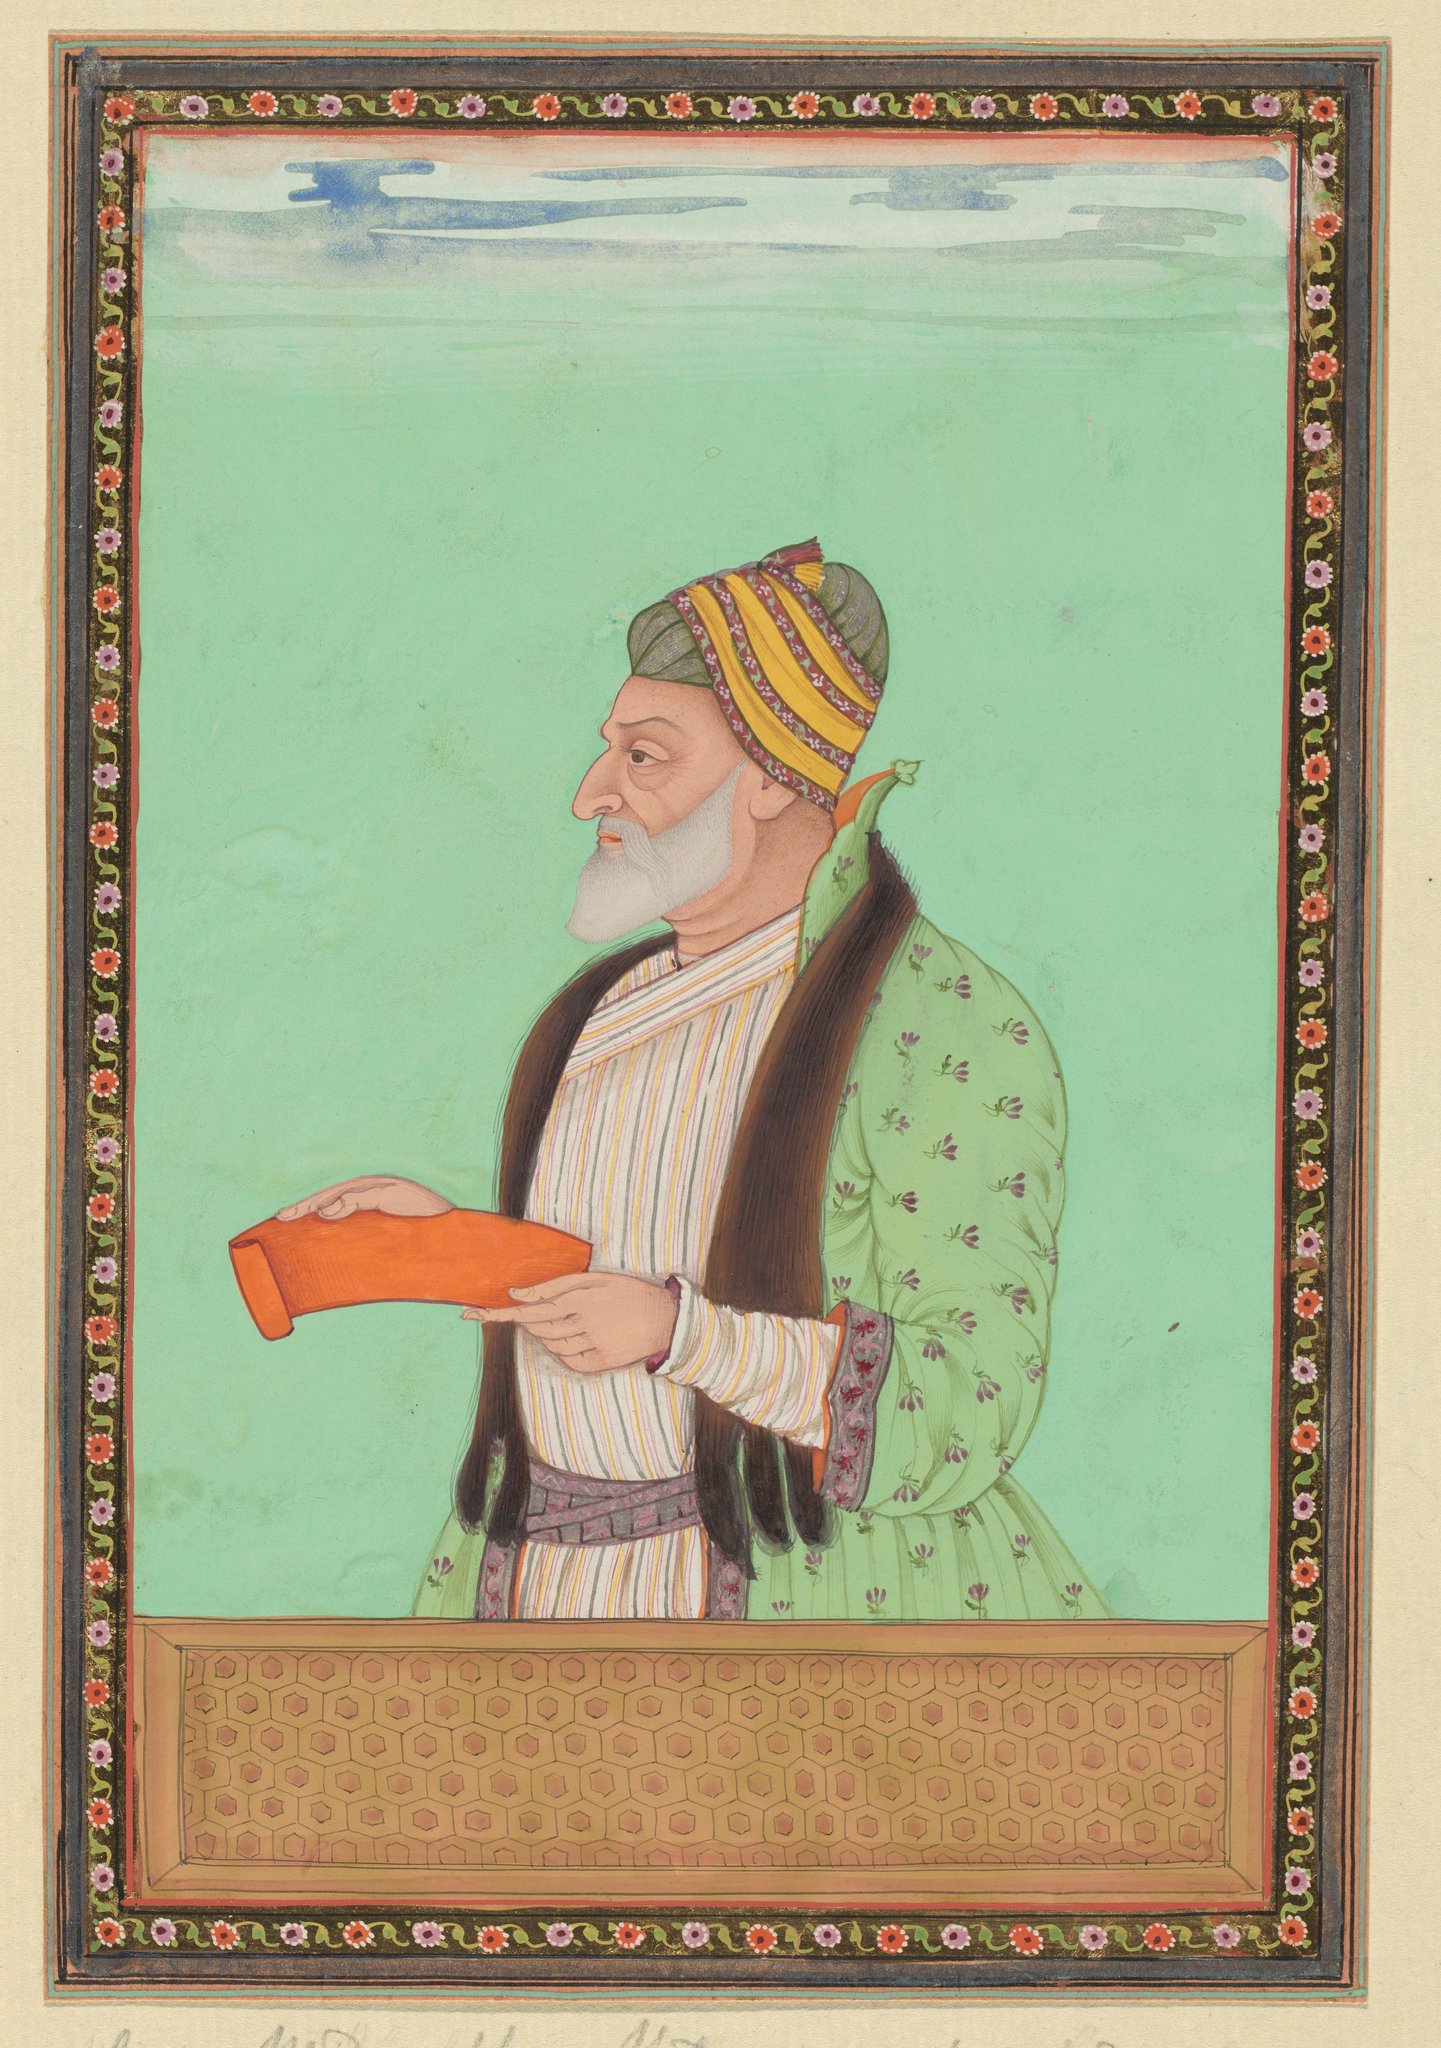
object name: indian miniature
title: Portret van Sayyid Muzaffar; ten tijde van Sultan Abul Hasan heeft hij als opperbevelhebber (peshwa) gediend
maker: Anonymous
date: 1686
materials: paint, gold leaf, gouache, paper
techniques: brush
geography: golkonda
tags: print maker, nicolaes cornelisz. witsen, historical person (...) - historical person (...) portrayed alone, ruler, sovereign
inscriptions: collector's mark: Lugt 240, annotation: ‘Seijd Muzaffer, Veldoverste ten tijde van Sultan Abuhassan’, collector's mark: Lugt 1838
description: Sayyid Muzaffar is tot aan zijn heupen afgebeeld, naar links gewend, in zijn handen een strook papier. Blad 28 in het `Witsen-Album', met 49 Indiase miniaturen van vorsten. Boven het portret een stukje papier met de naam in het Perzisch. Onder het portret een stukje papier met de naam in het Portugees.